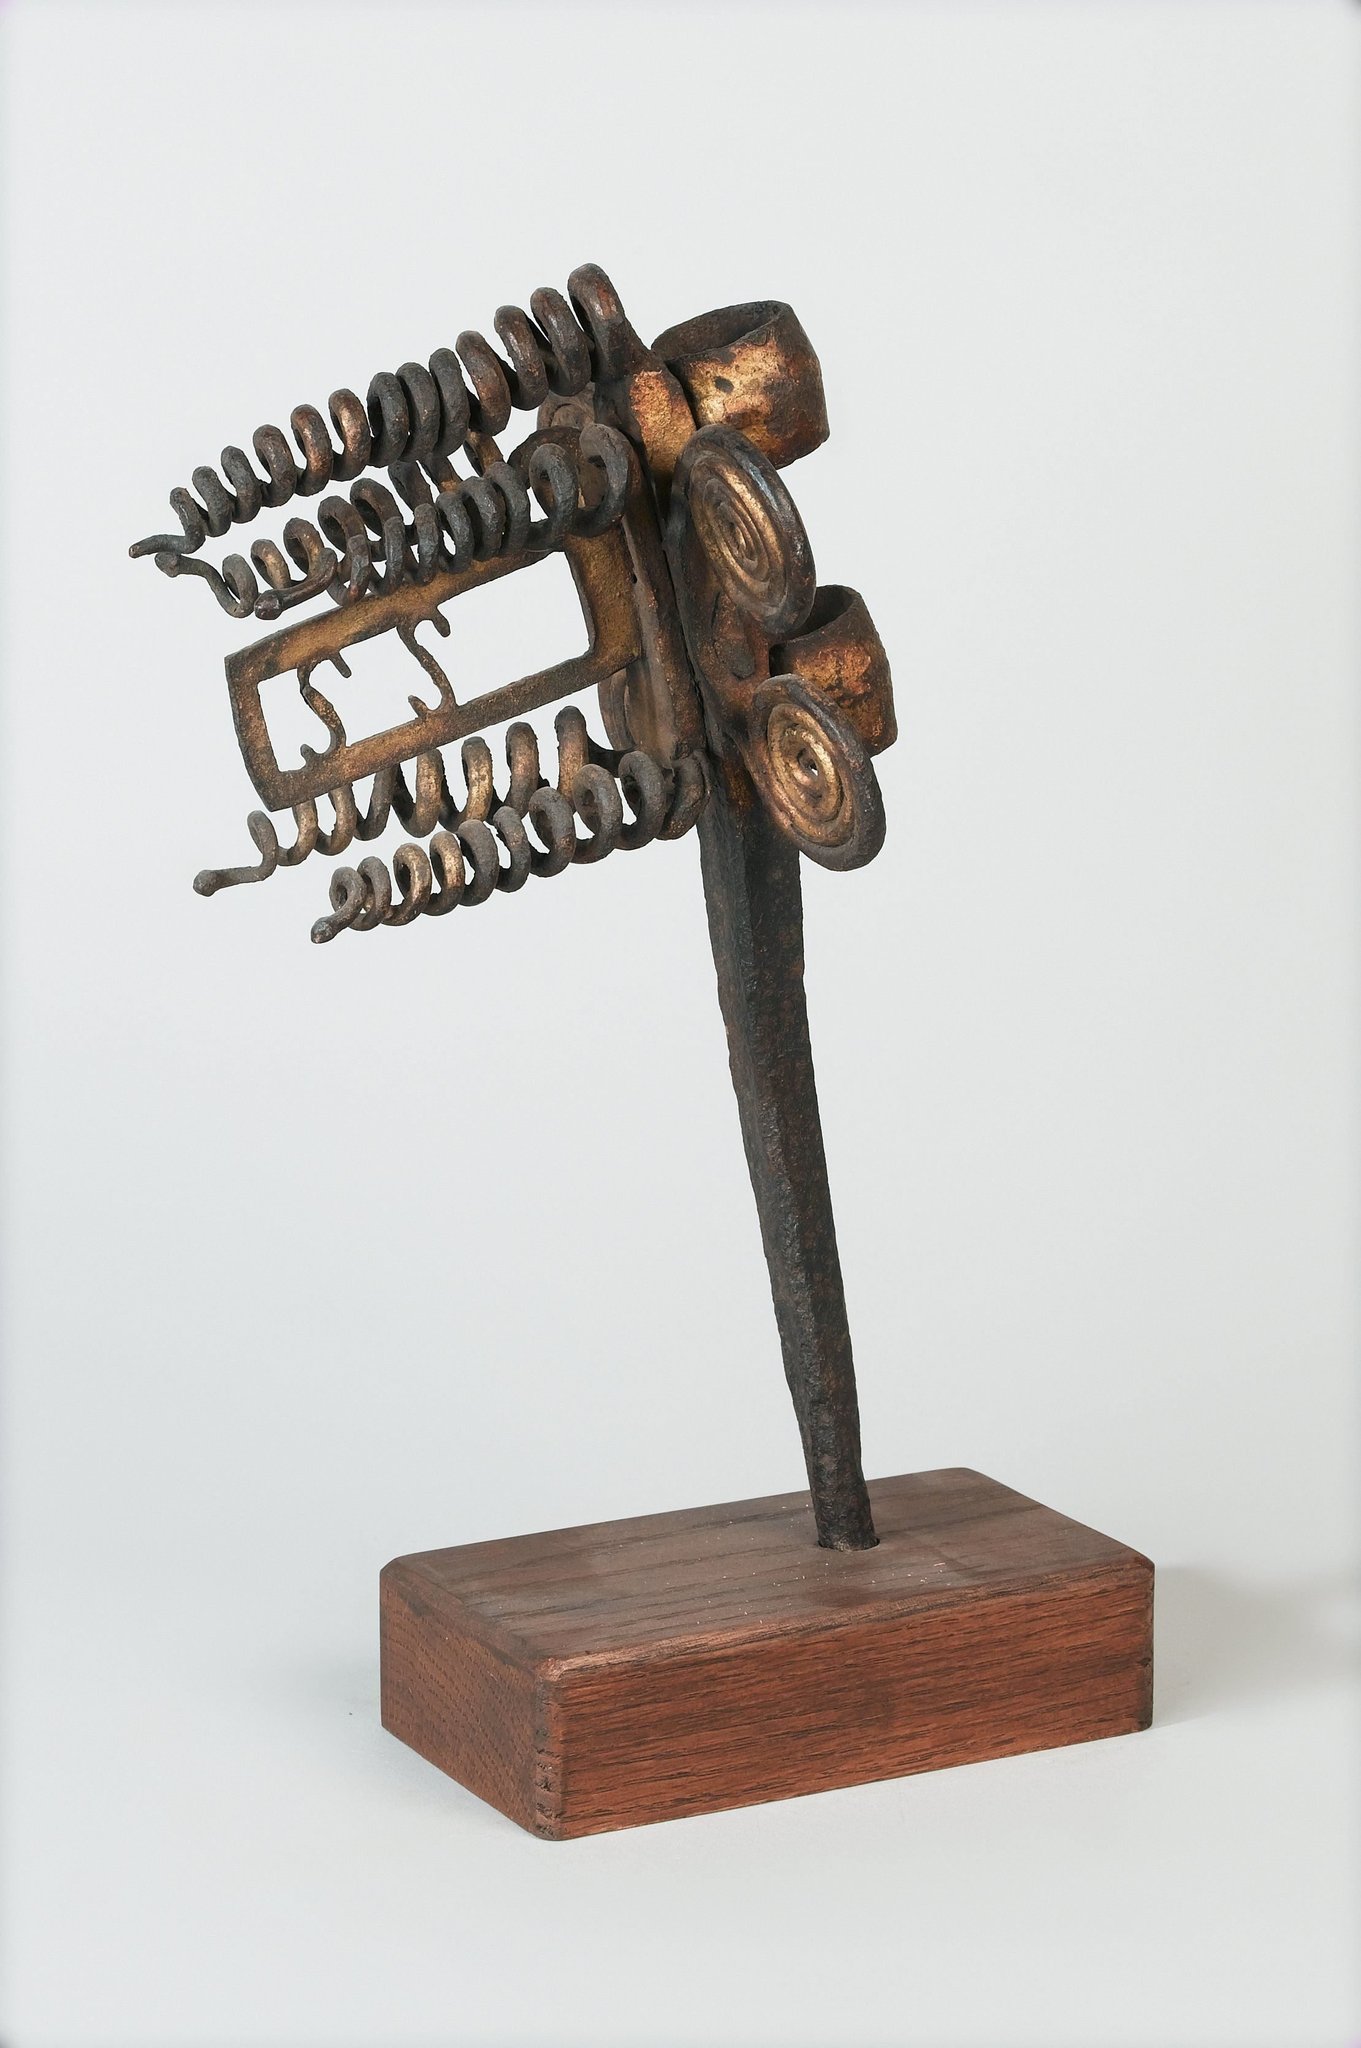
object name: flagpole holder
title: Vlaggenstokhouder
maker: Anonymous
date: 1700-1850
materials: wood, iron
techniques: forging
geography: netherlands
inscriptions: inscription: ‘SS’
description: Vlaggenstokhouder versierd met vier platte en vijf kegelvormige spiralen en een metalen plaatje waarin de letter 'SS' zijn uitgezaagd. Met twee aangeklonken ringen, waarin de vlaggestok gestoken kan worden. Op de houder resten van bronskleur.